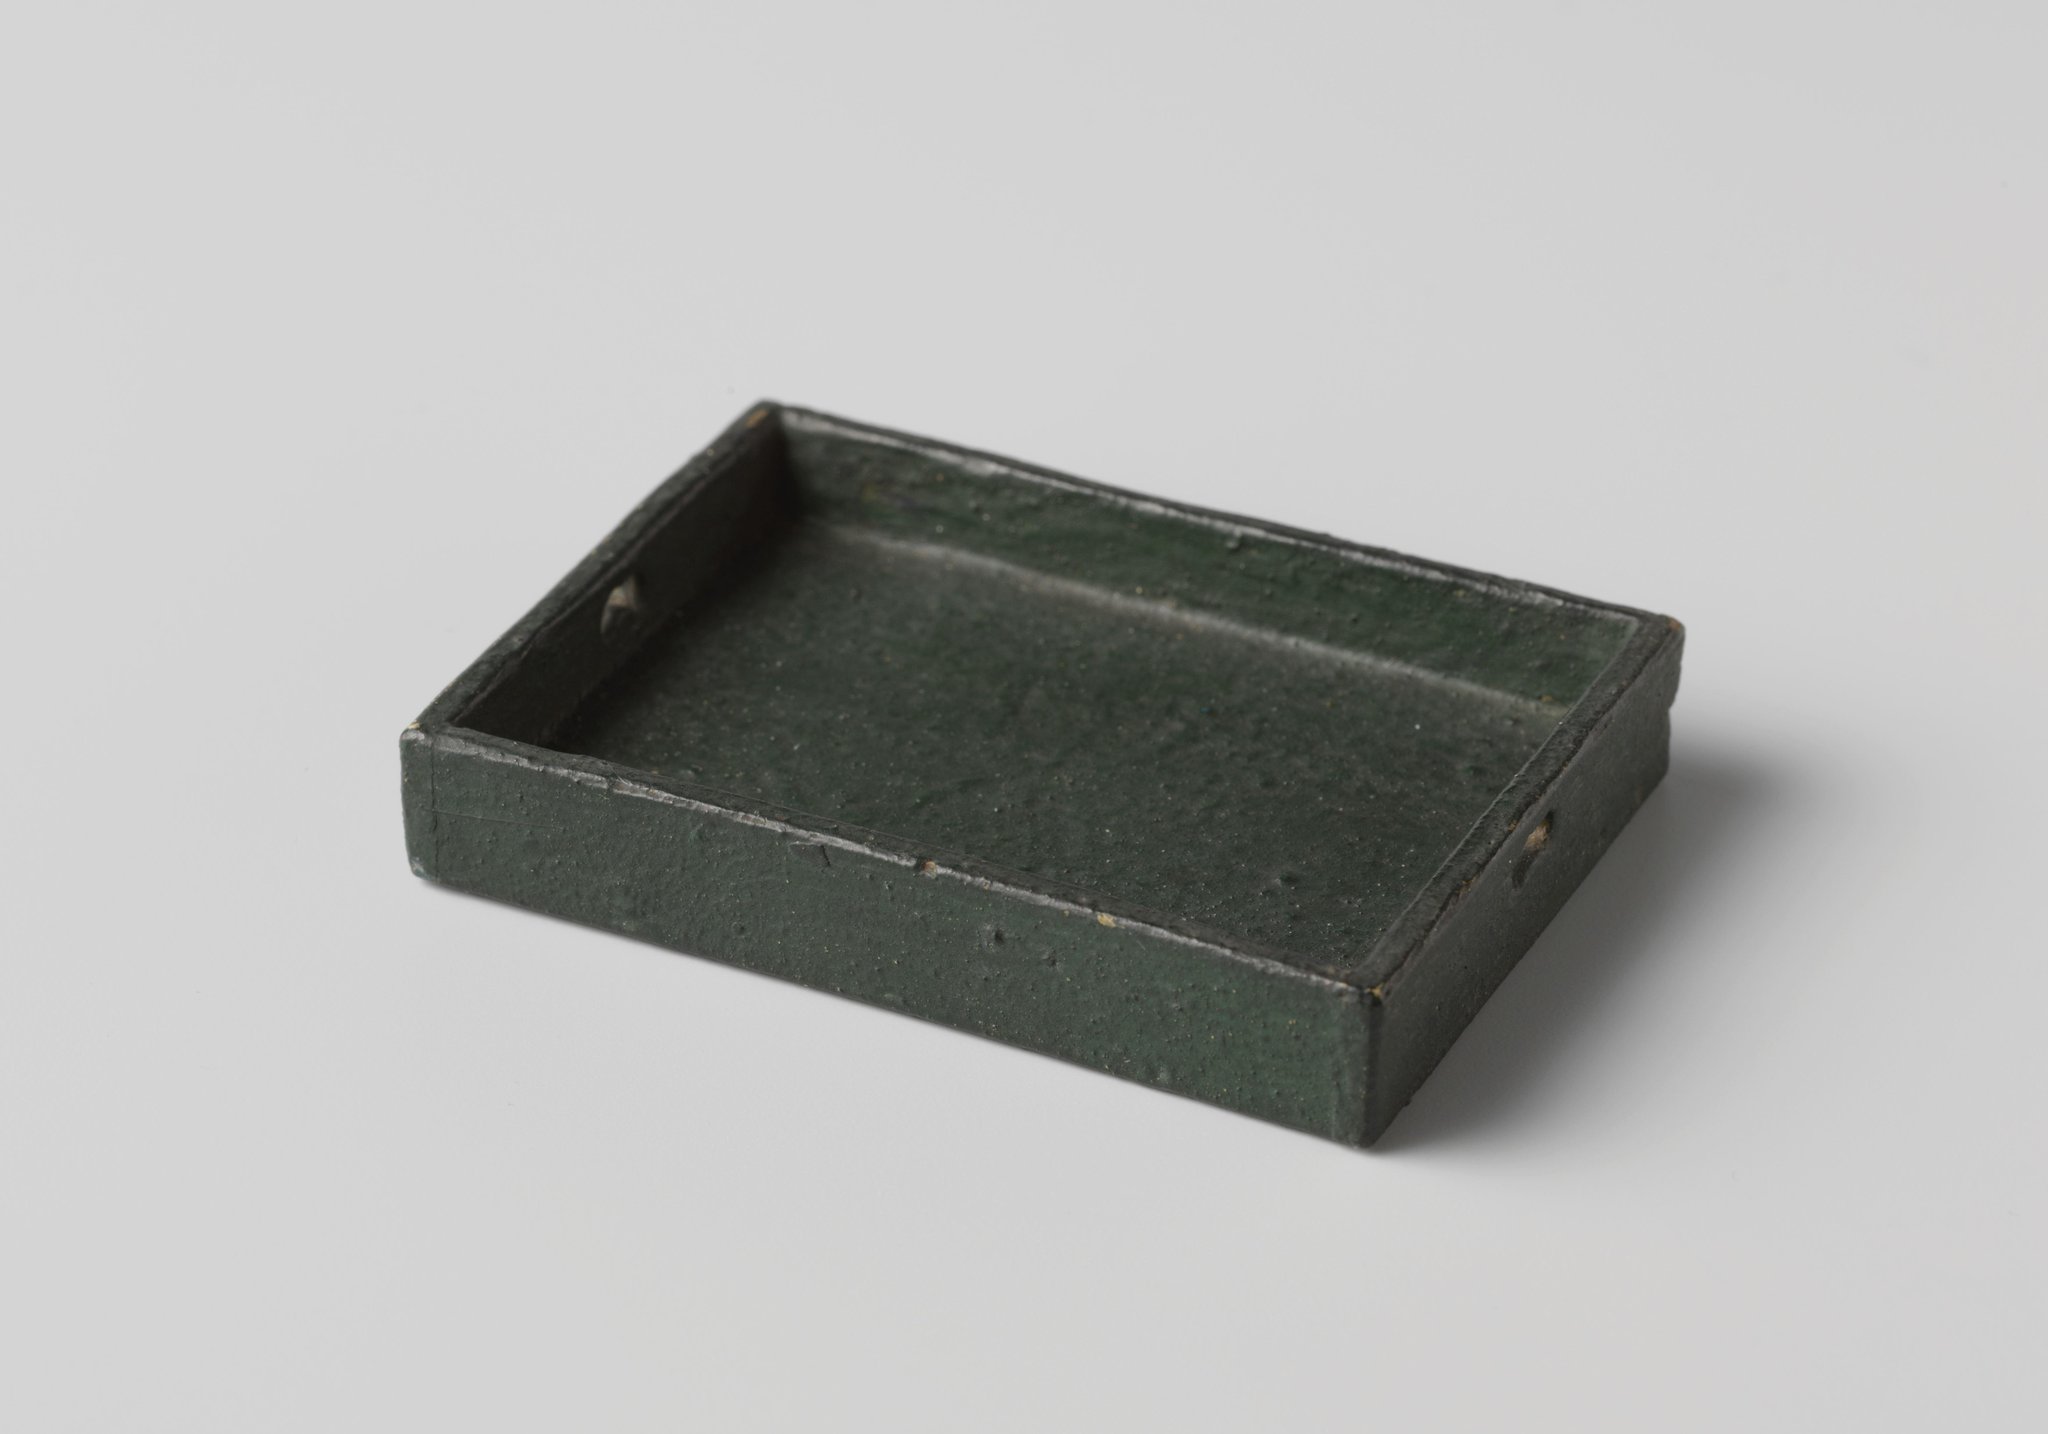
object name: miniature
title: Schenkbak met uitgezaagde handgrepen, groengeverfd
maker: Anonymous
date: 1700-1799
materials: wood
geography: amsterdam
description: Dienblad van groengeverfd hout met uitgezaagde handgrepen in de korte zijde.